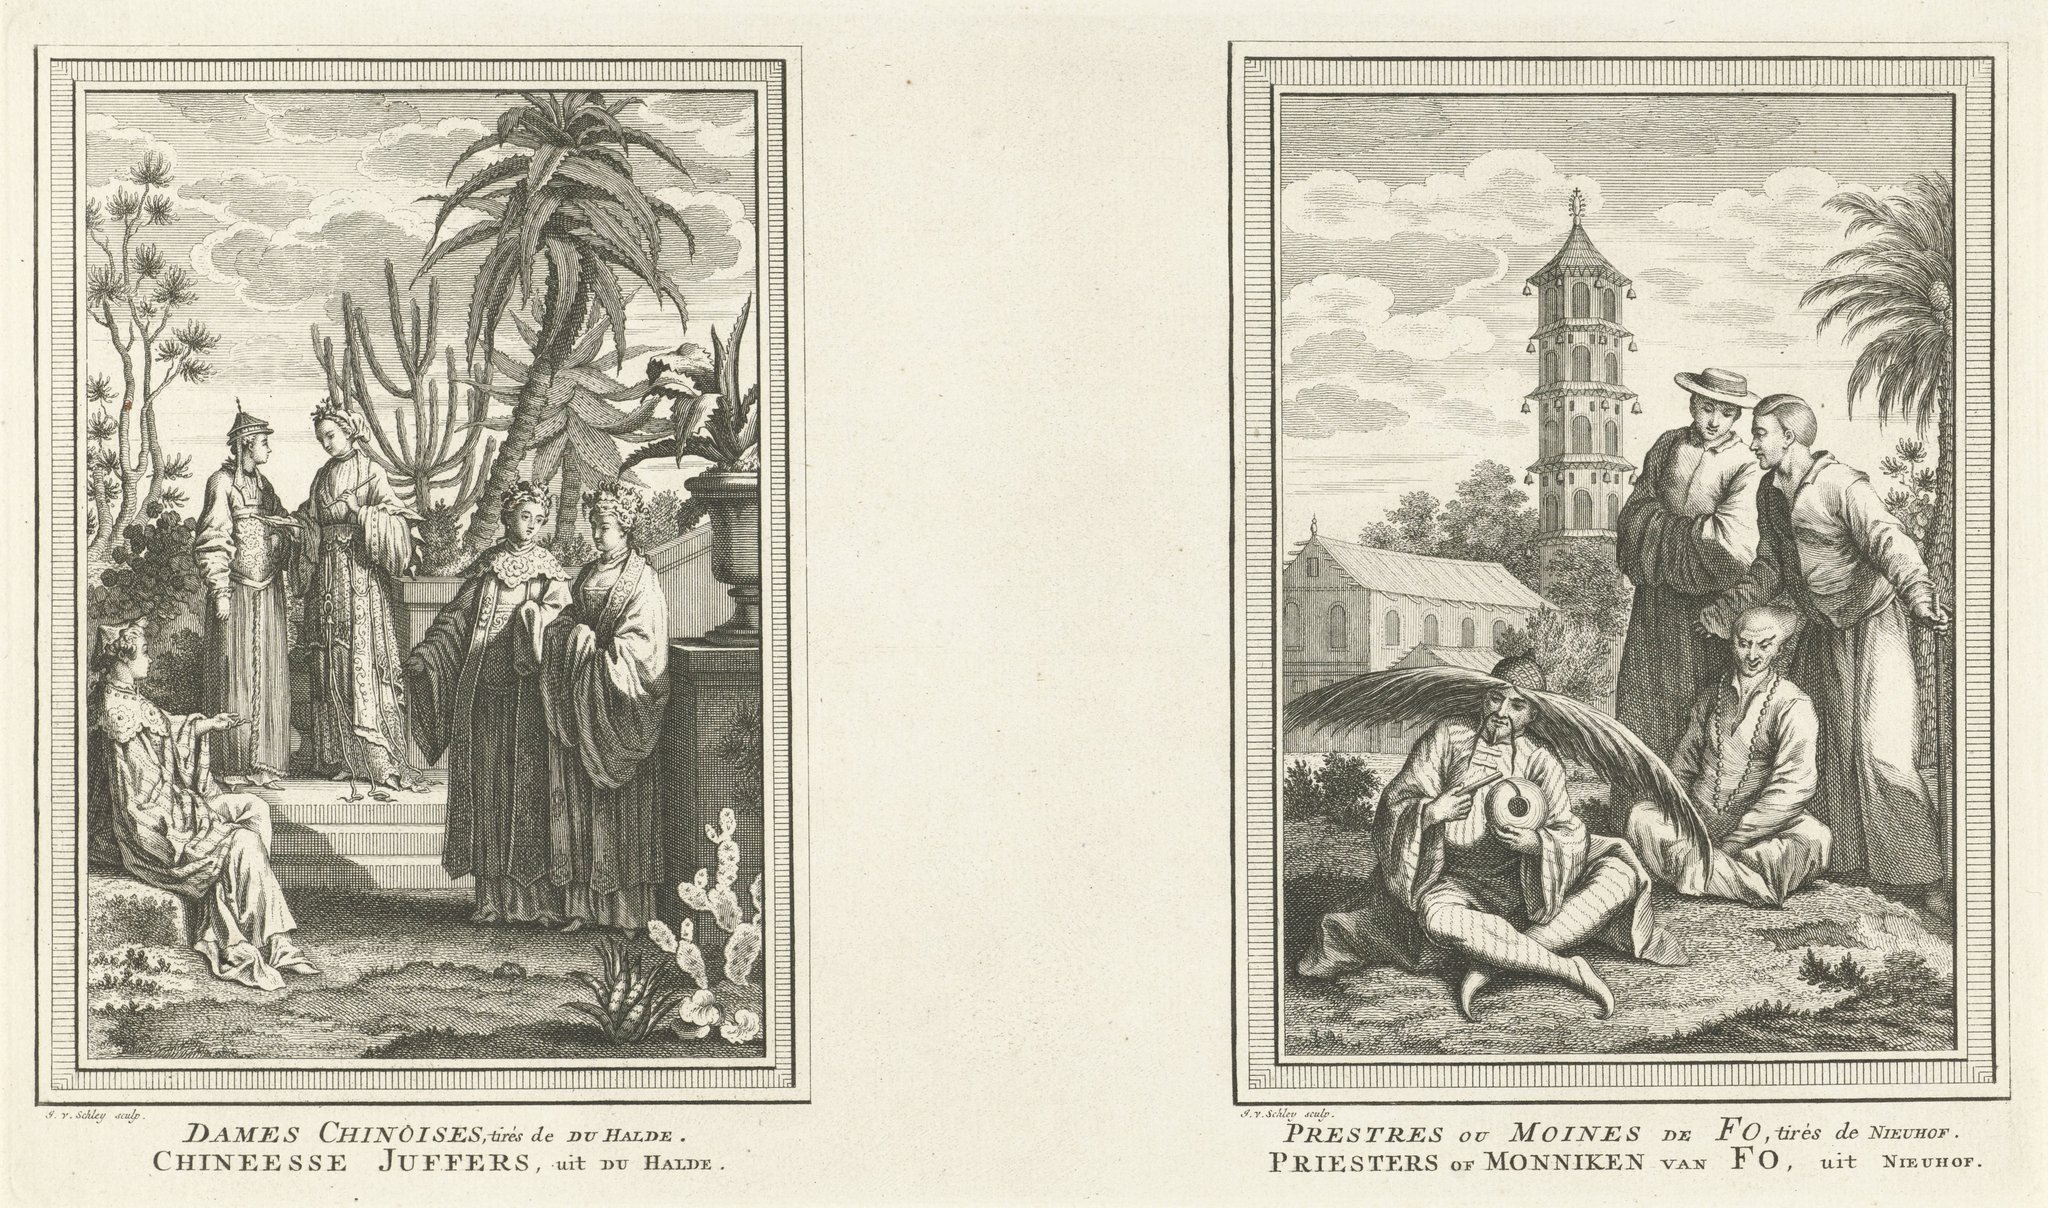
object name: print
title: Chinese vrouwen en priesters van Fo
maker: jacob van der schley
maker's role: draughtsman, print maker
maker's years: 1715-1779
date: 1725-1779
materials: paper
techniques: engraving, etching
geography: amsterdam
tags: chinese, garden, landscapes in tropical and sub-tropical regions, monk(s), friar(s)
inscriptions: collector's mark: Lugt 2233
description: Blad met twee afbeeldingen. Links Chinese vrouwen in een tuin. Rechts de monniken van Fo.